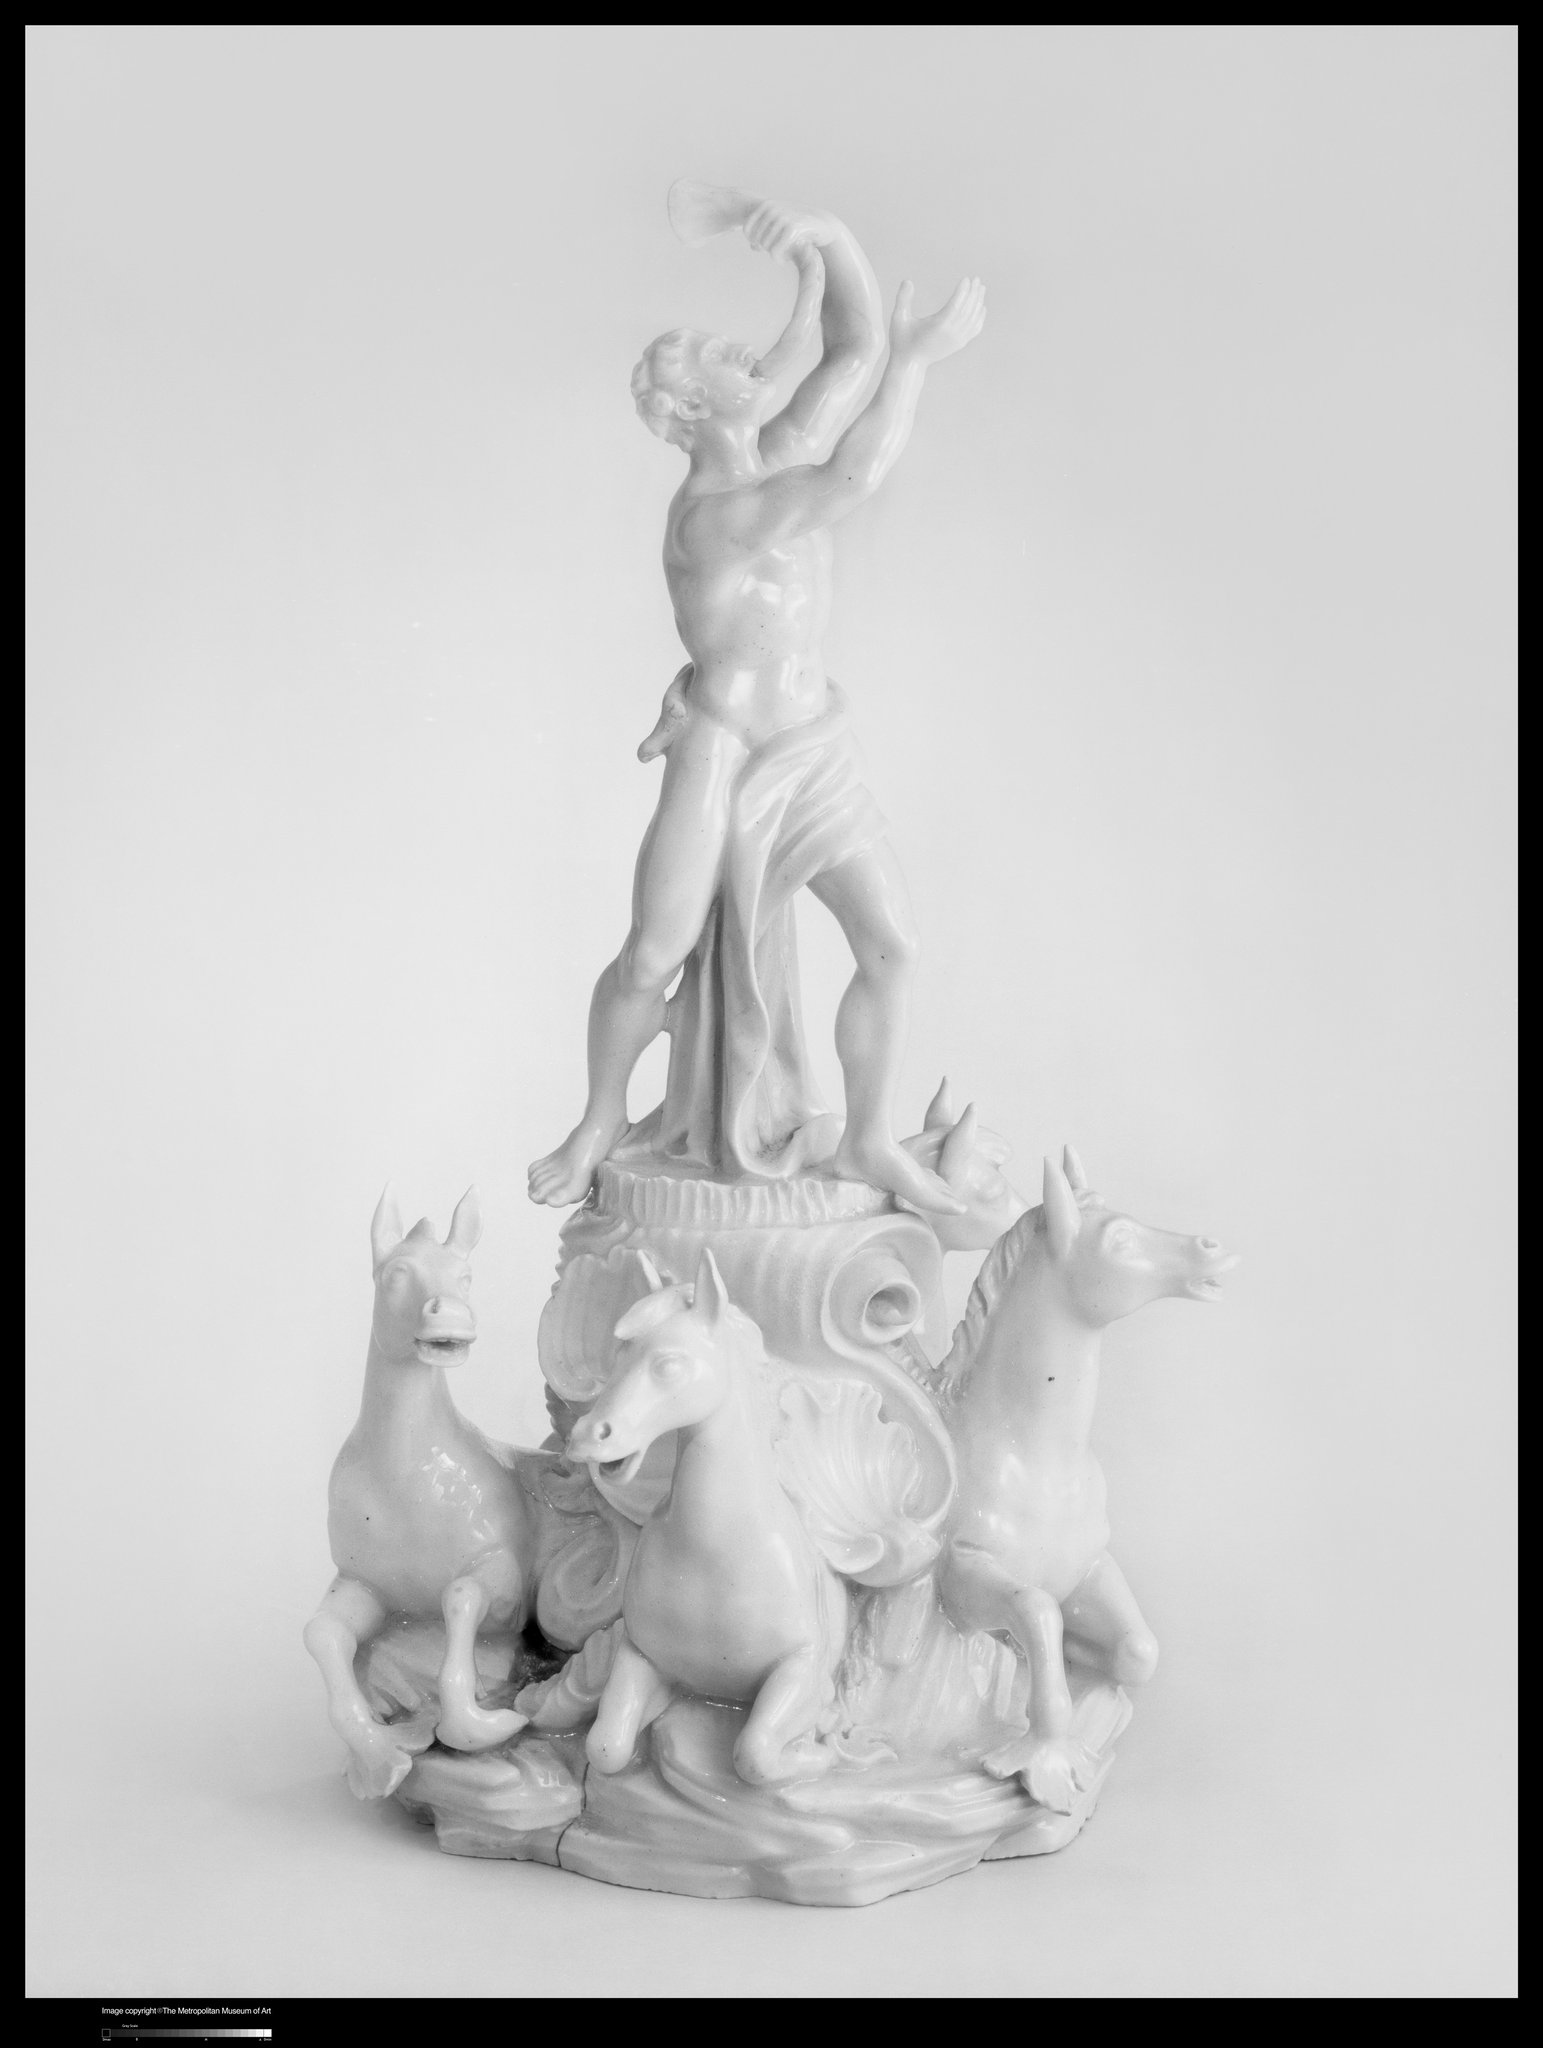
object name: centerpiece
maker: cozzi manufactory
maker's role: factory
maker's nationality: italian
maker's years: 1764-1812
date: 1770-1780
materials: hard paste porcelain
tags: neptune,seahorses